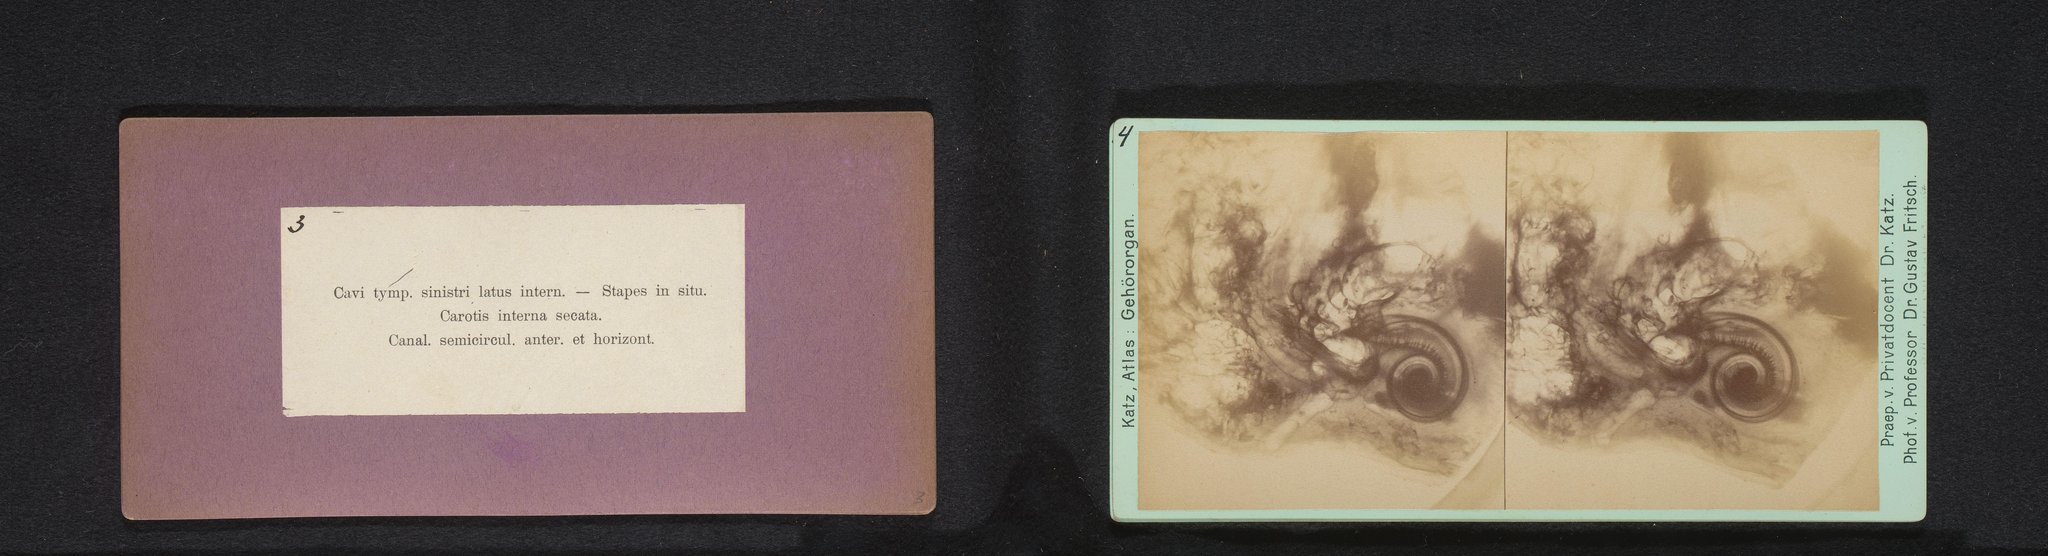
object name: stereograph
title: Katz, Atlas: Gehörorgan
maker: gustav fritsch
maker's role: professor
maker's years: 1838-1927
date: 1885-1895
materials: photographic support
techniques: albumen print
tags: ears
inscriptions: number: ‘4’